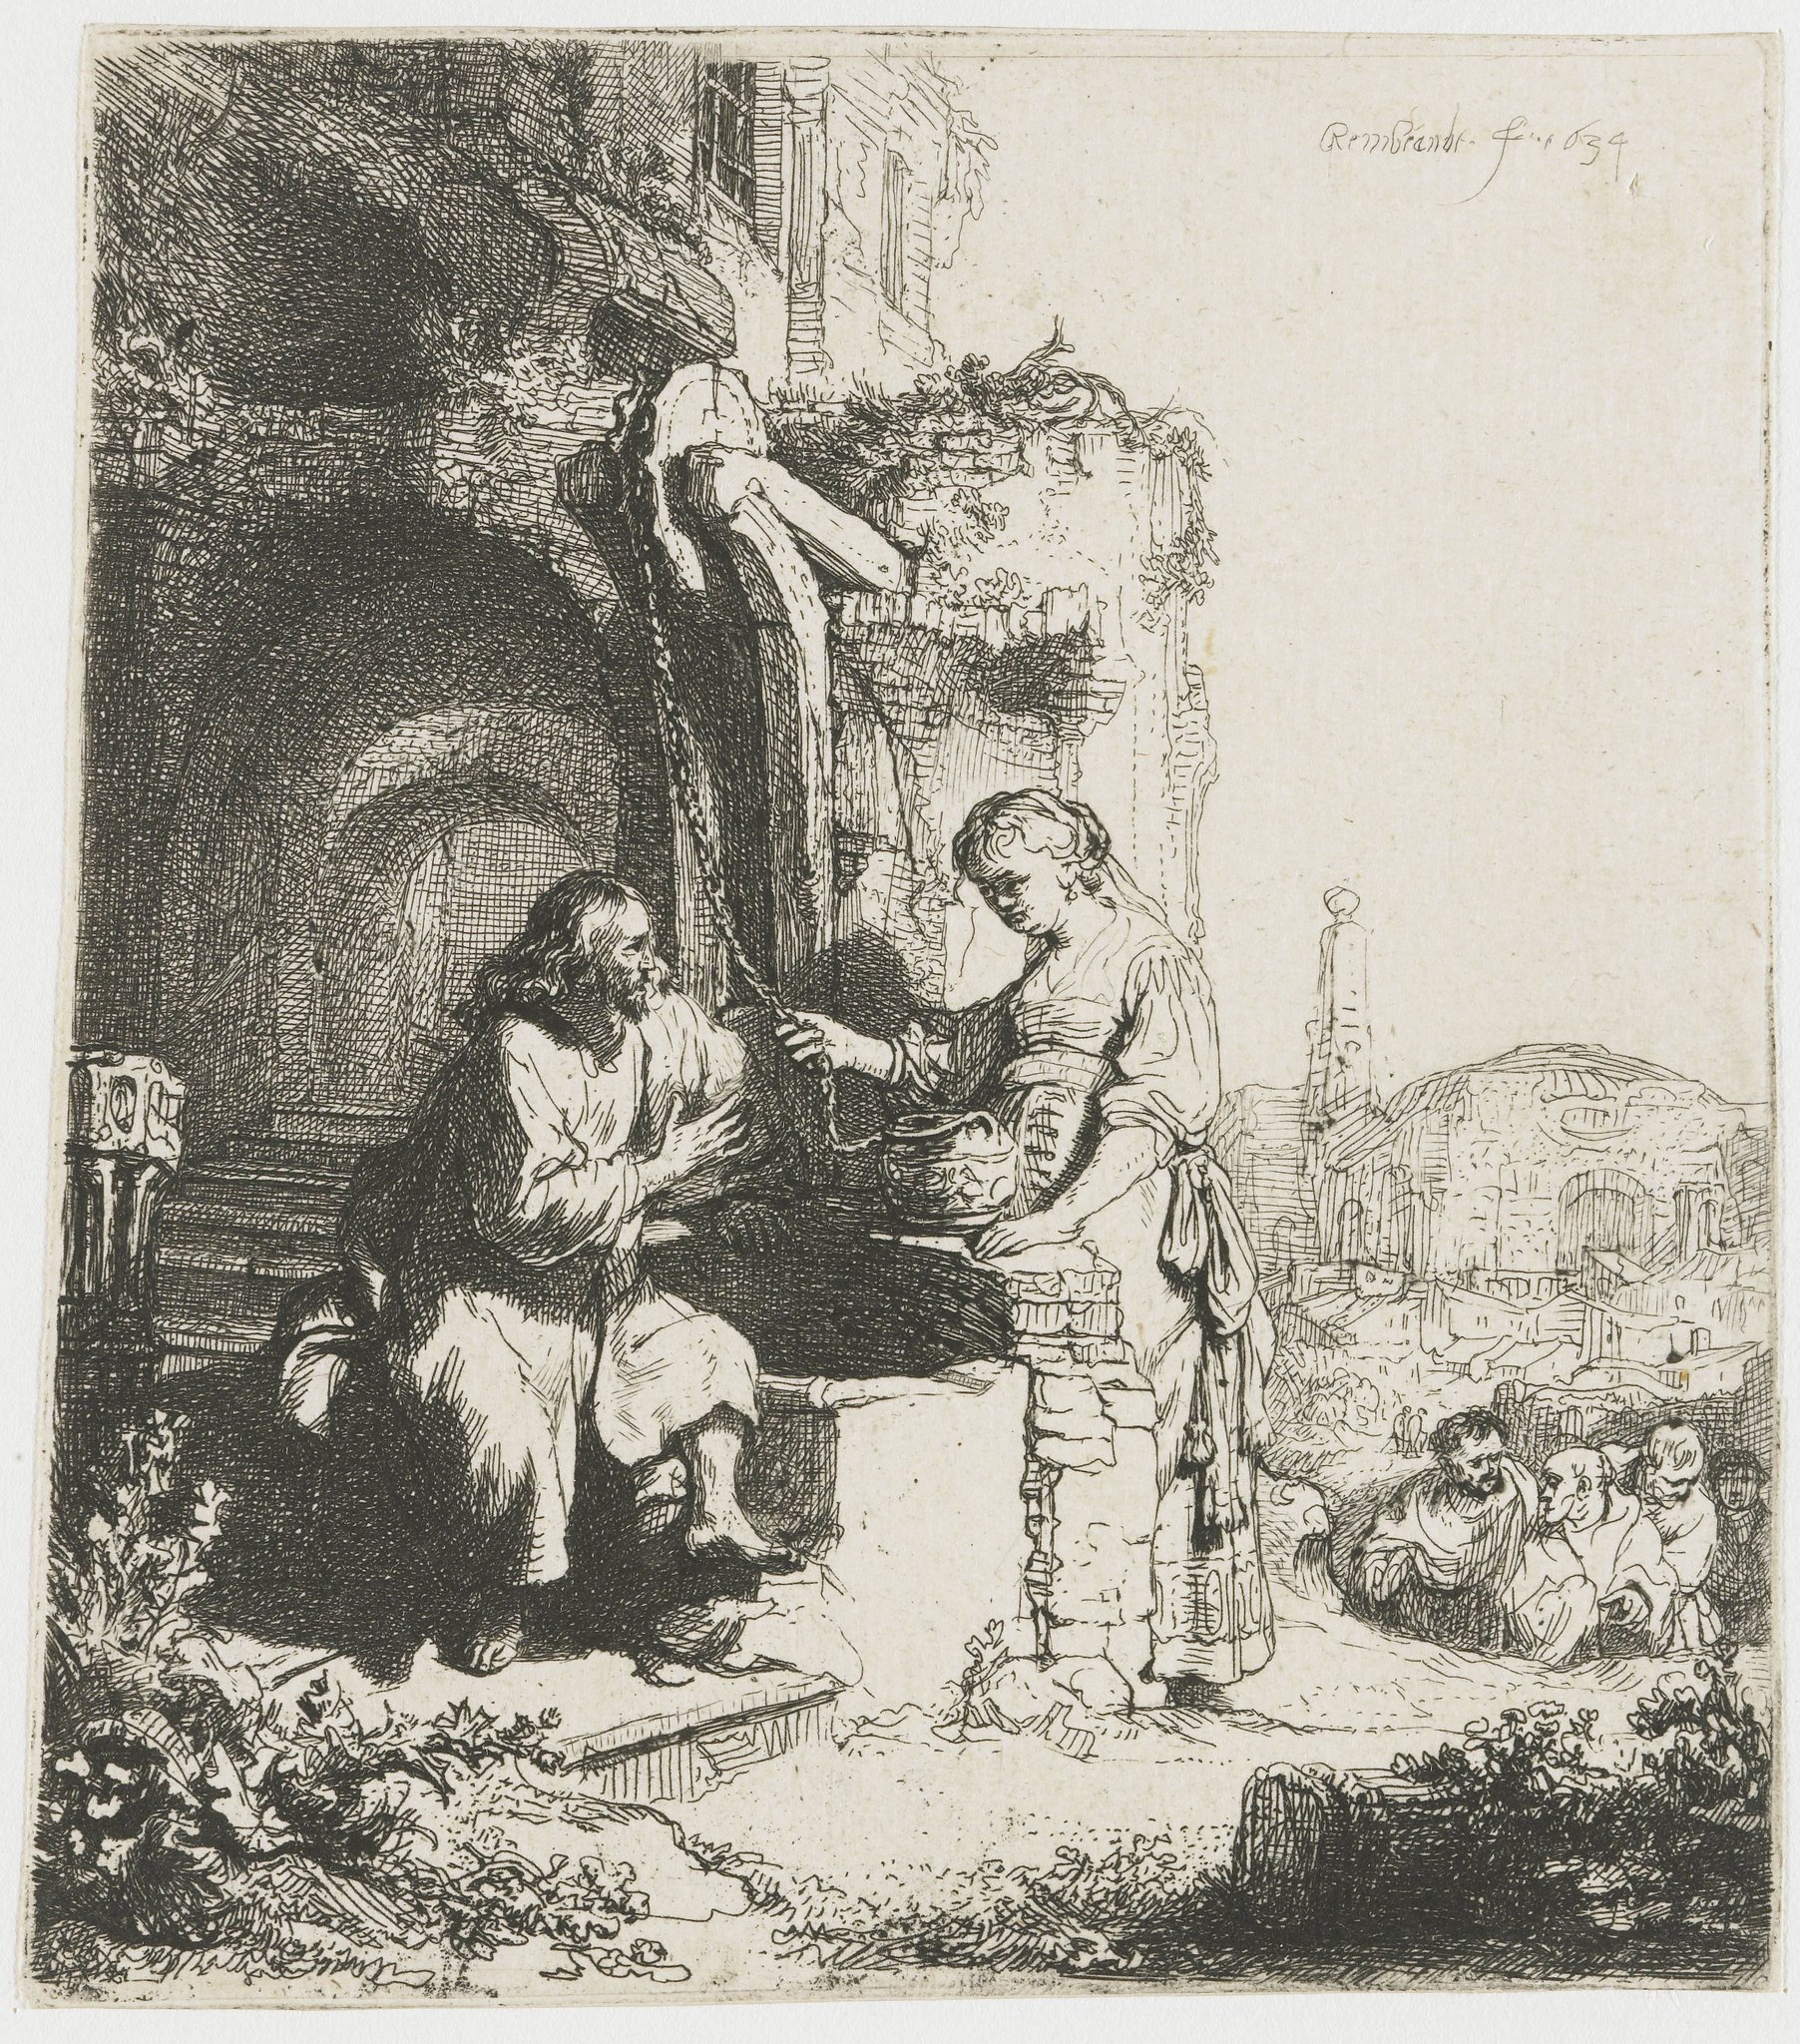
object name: print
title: Christ and the woman of Samaria among ruins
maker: rembrandt van rijn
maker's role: draughtsman, painter, print maker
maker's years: 1606-1669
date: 1634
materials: paper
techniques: etching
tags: the woman of samaria (john 4:4-42)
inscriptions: signature and date: ‘Rembrandt f. 1634’, mark: Lugt 2228